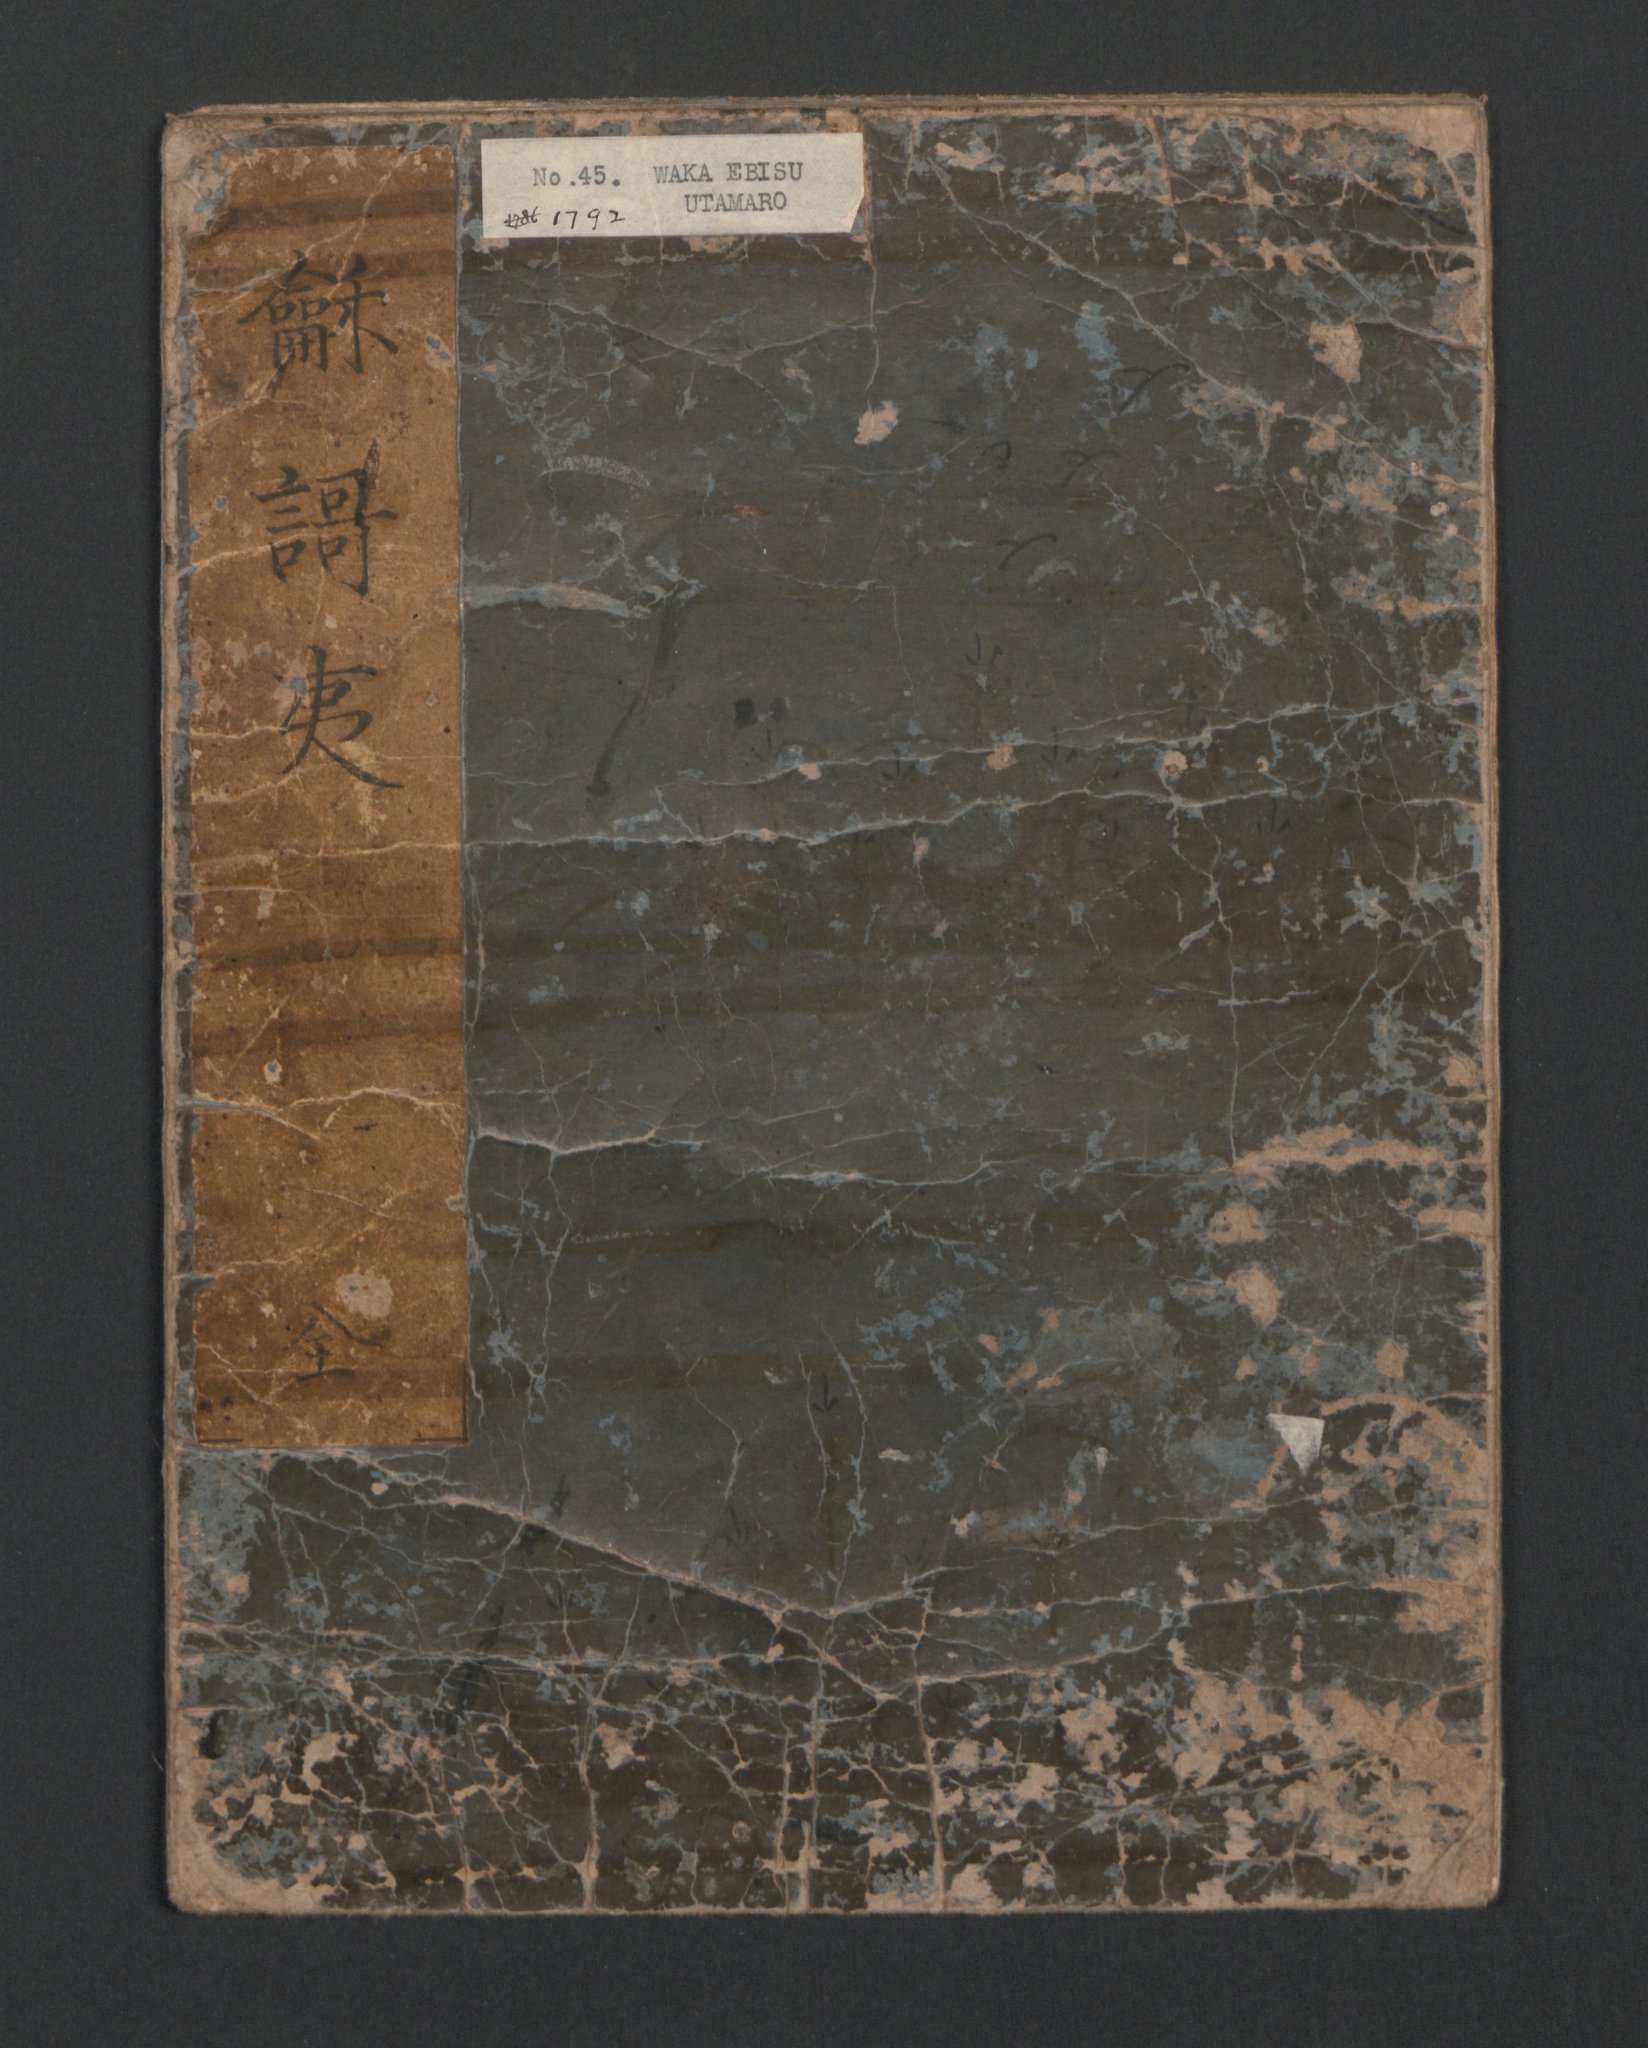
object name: illustrated book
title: Picture Book with Playful Poems for the Young God Ebisu (Ehon waka Ebisu) 絵本龢謌夷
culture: japanese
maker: kitagawa utamaro 喜多川歌麿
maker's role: artist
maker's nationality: japanese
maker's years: 1754-1806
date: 1792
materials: ink, paper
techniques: polychrome, woodblock print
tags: human figures,poetry,buildings